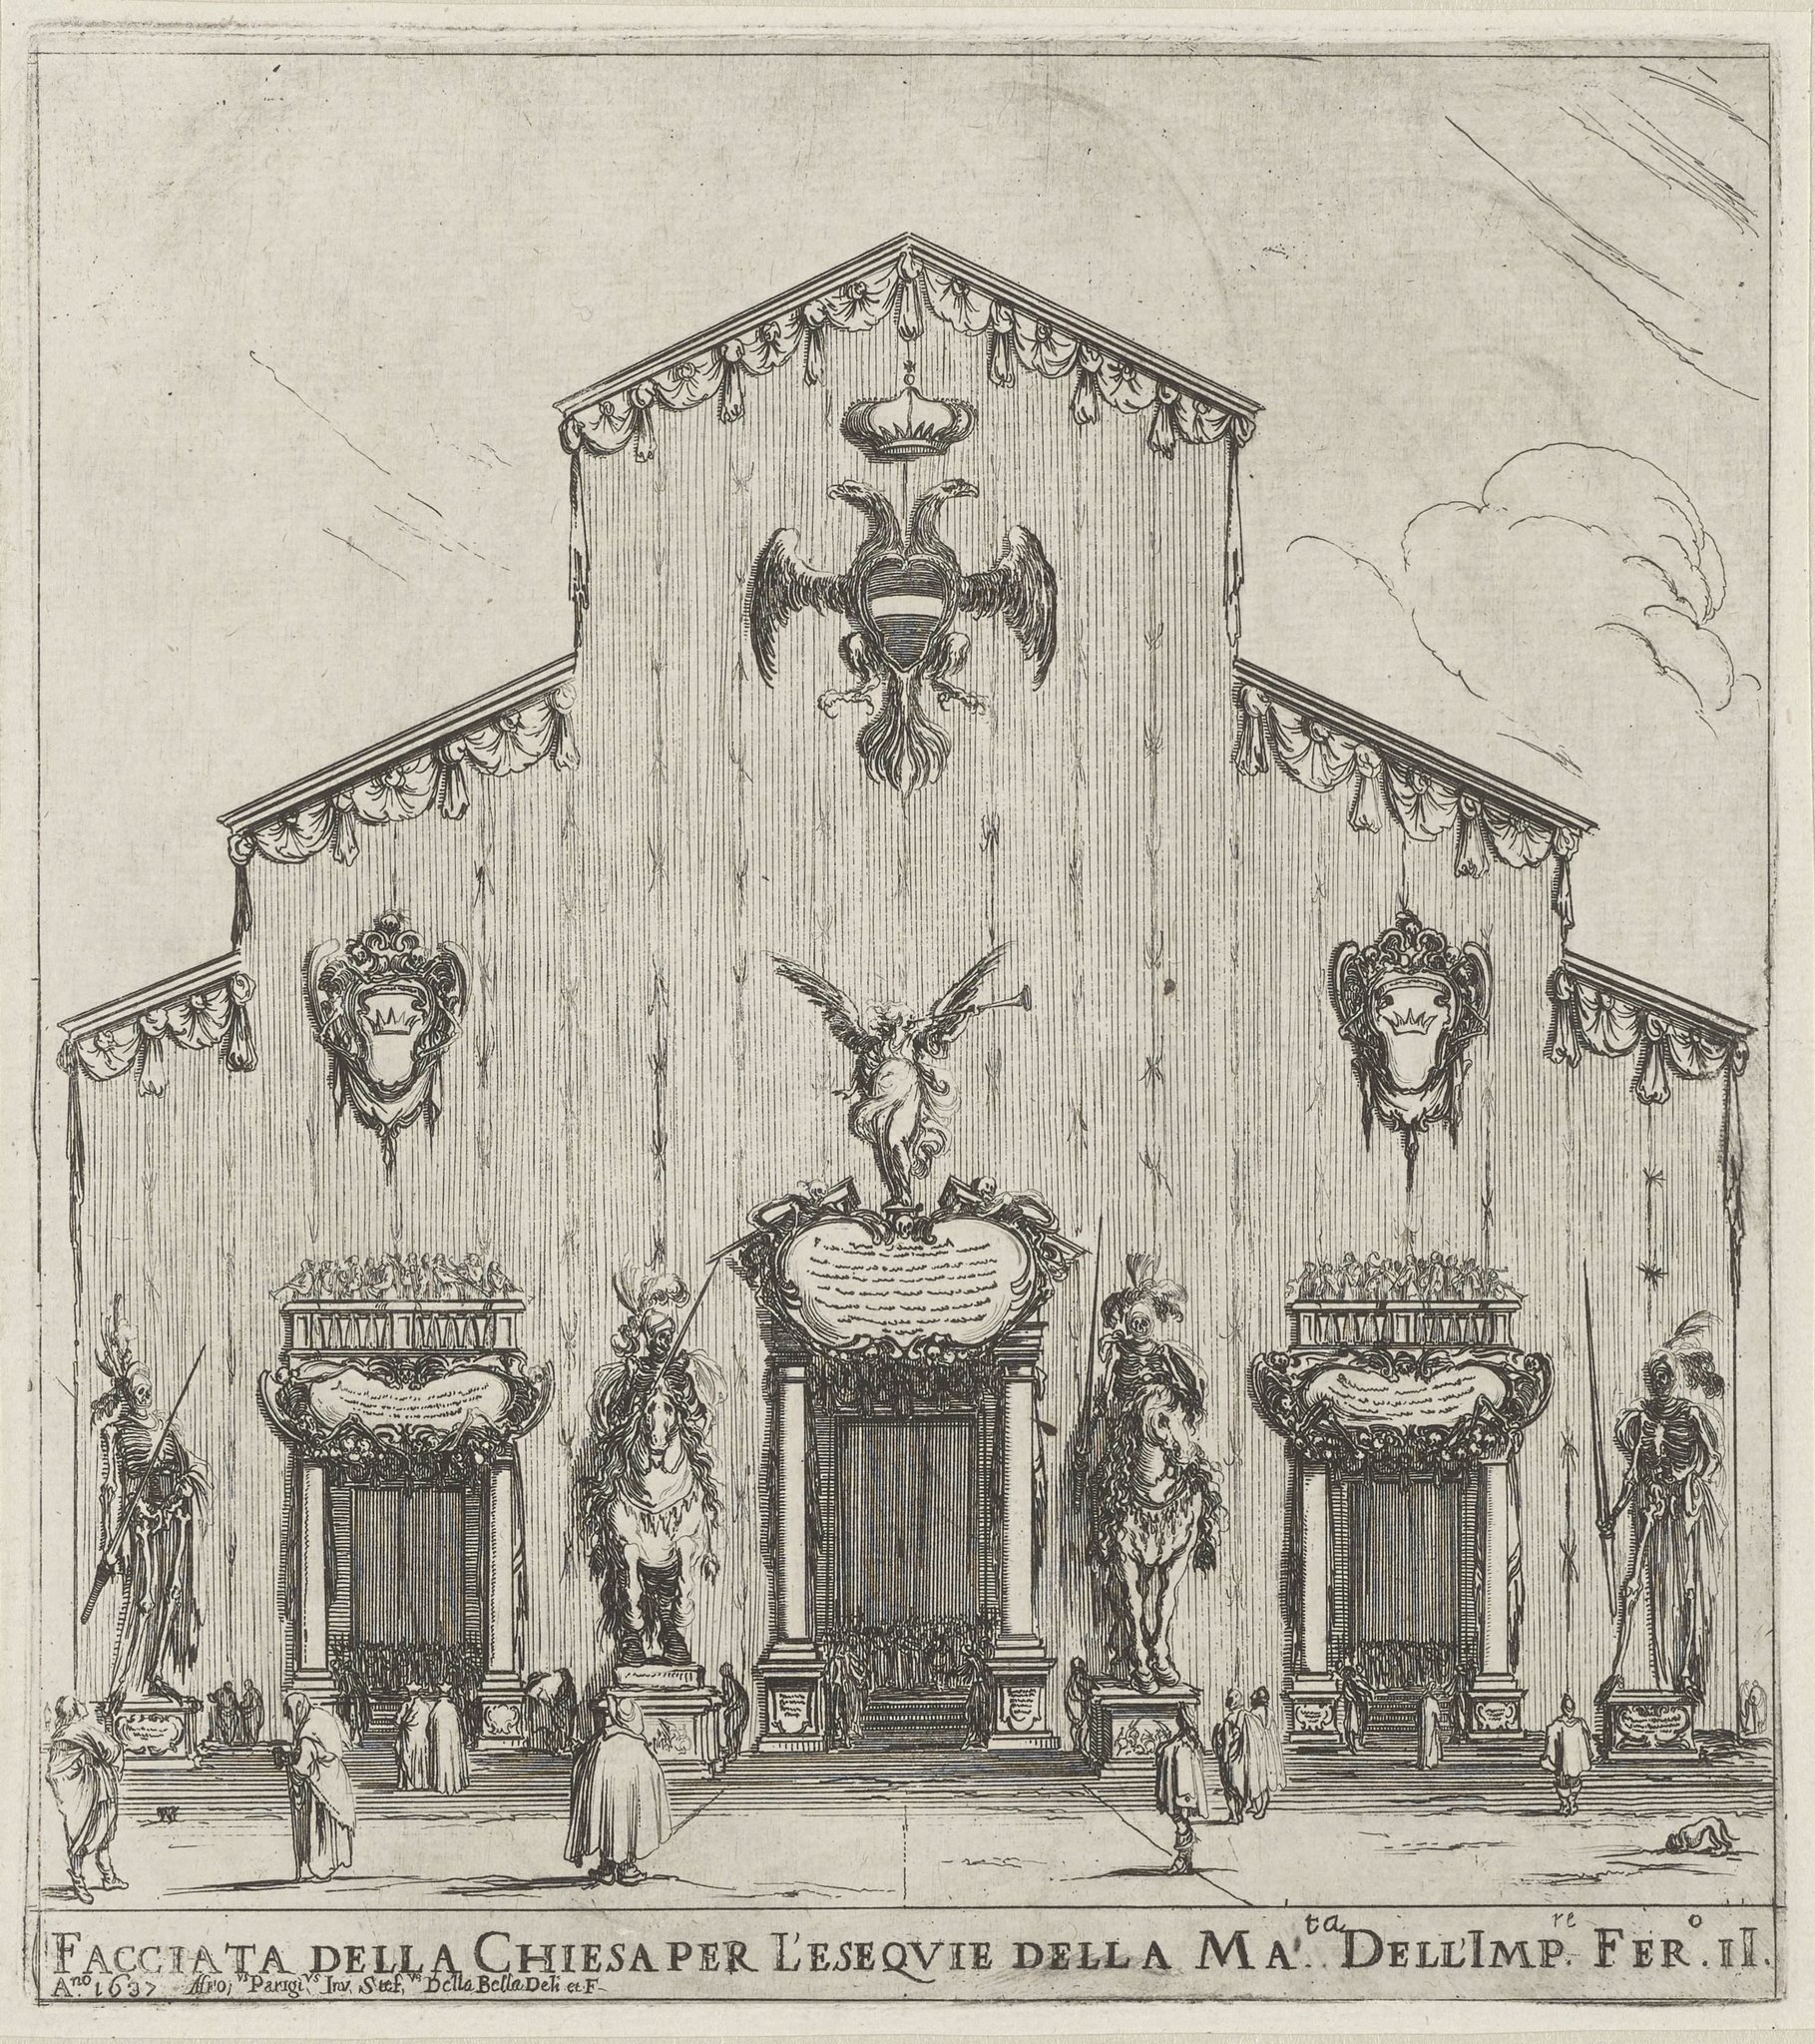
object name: ornament print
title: Begrafenis van keizer Ferdinand II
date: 1637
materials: paper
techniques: etching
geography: italy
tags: ferdinand ii (duits keizer), church (exterior), funerary ceremonial, parts of church exterior and annexes: façade, public funeral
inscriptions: collector's mark: Lugt 240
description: Façade van de San Lorenzo in Florence. De kerk is versierd ter ere van de begrafenis van keizer Ferdinand II. Op de gevel het wapen van keizer Ferdinand II. Voor de gevel staan vier beelden van skeletten, waarvan twee te paard. Op balkons boven de deuren staan muzikanten. Boven de centrale deur staat een engel. Titel in ondermarge.